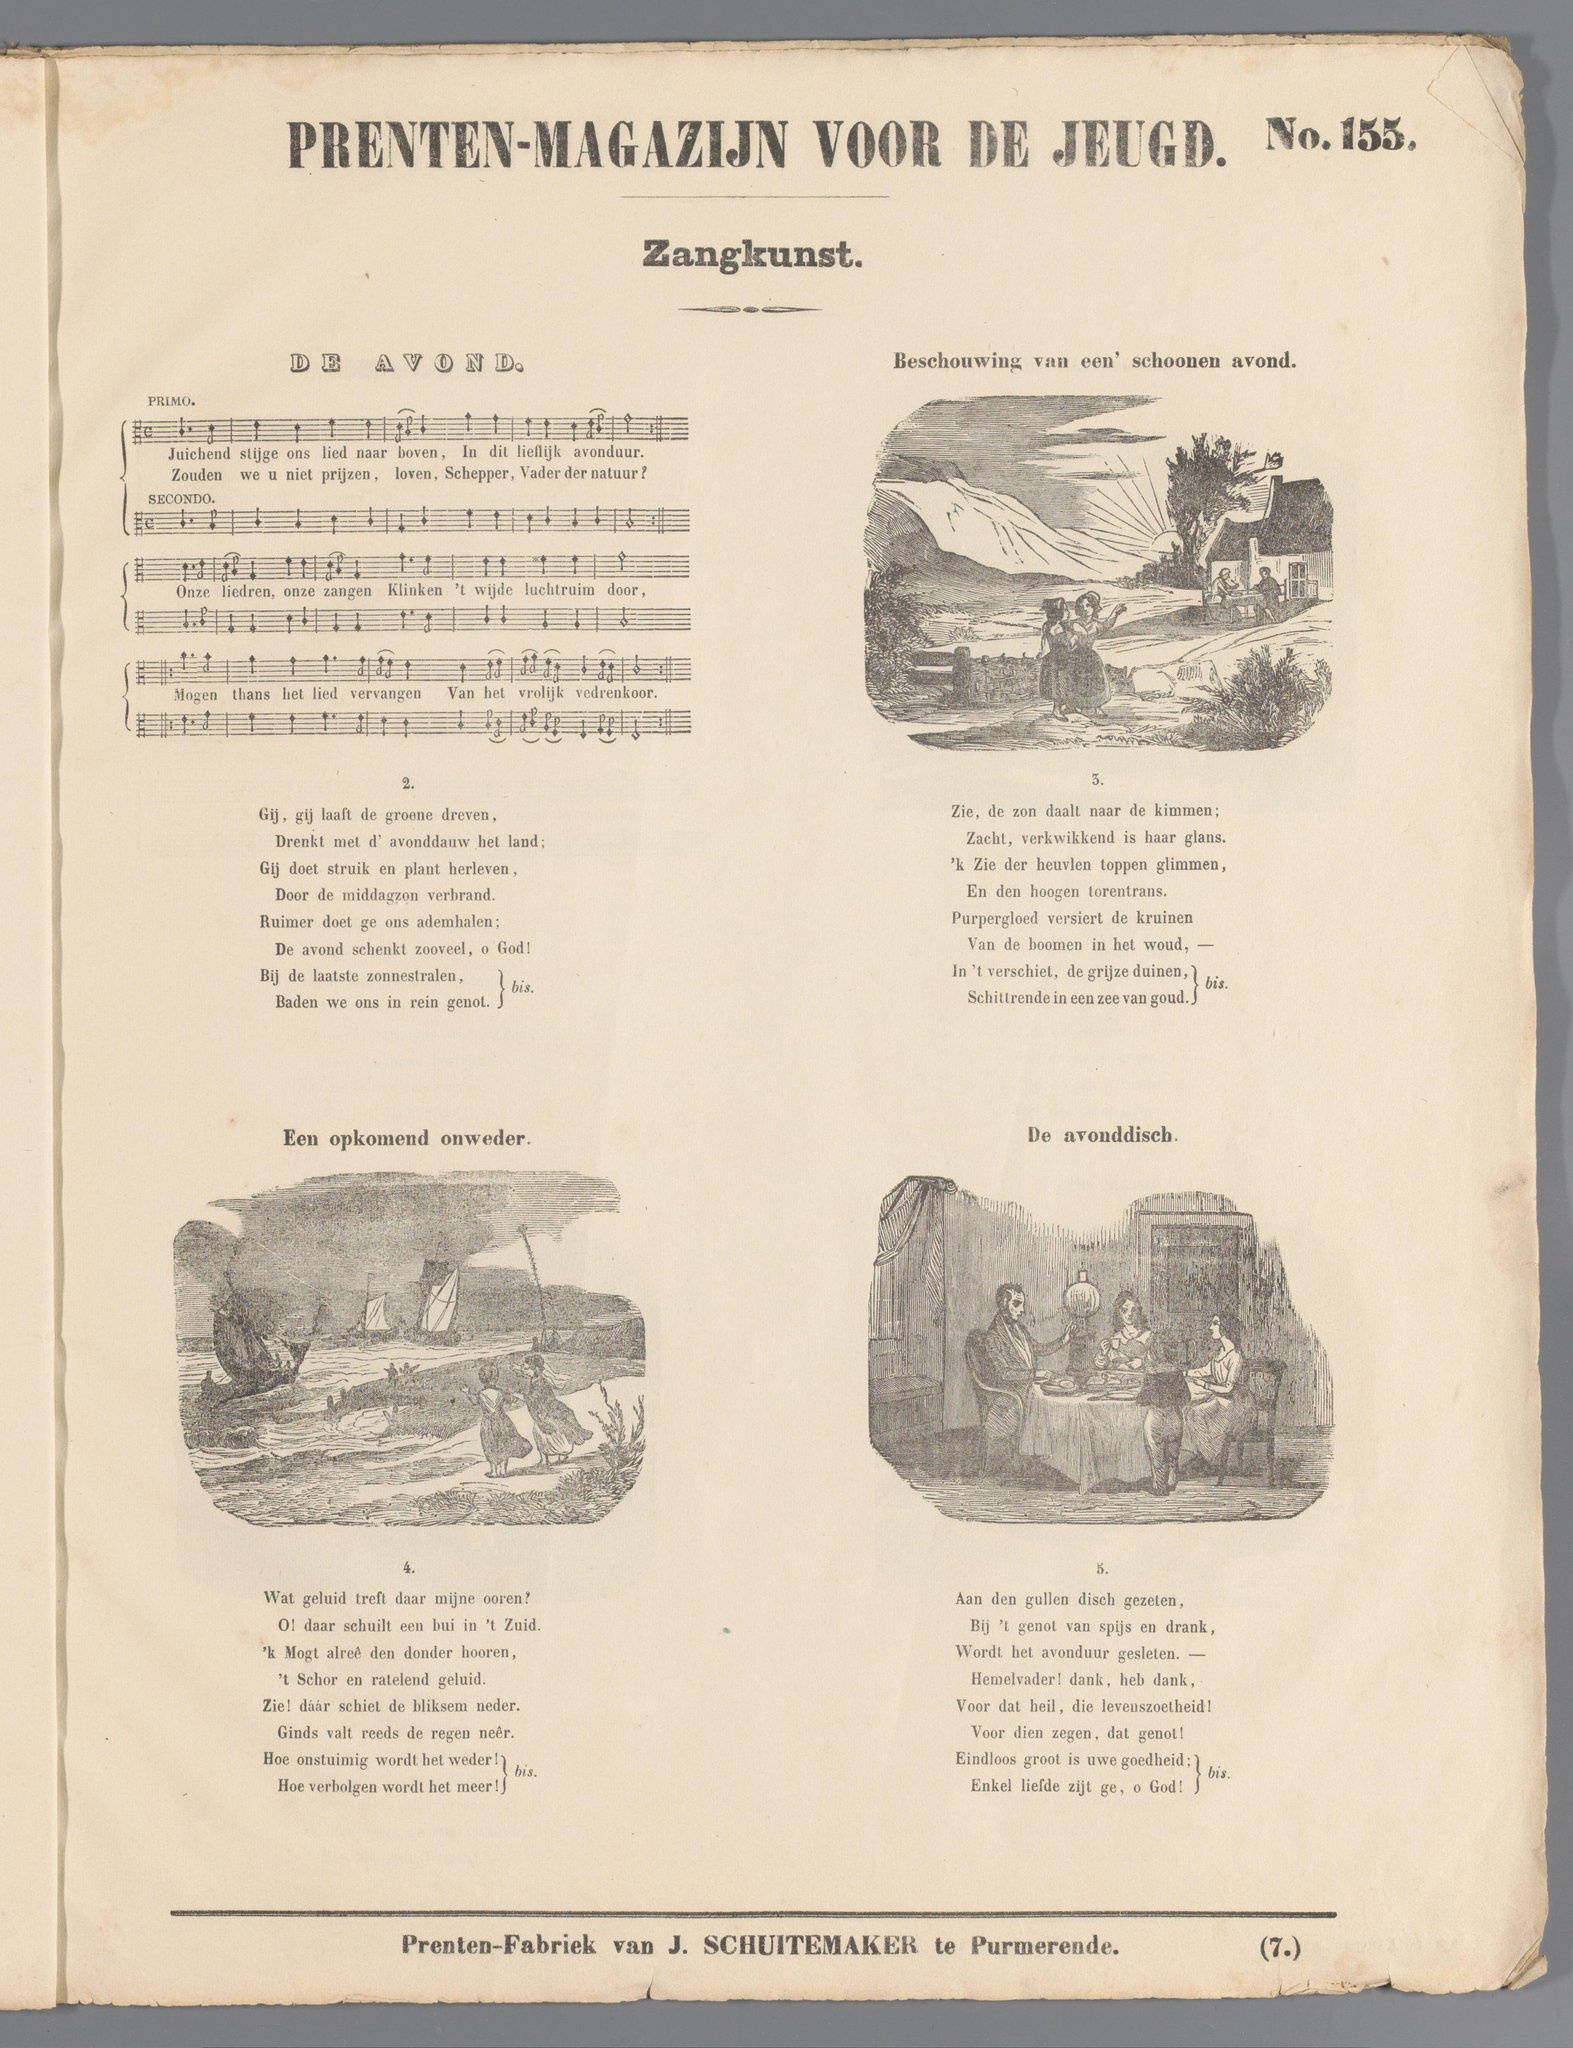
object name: print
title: Prenten-magazijn voor de jeugd / Zangkunst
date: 1853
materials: paper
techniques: letterpress printing, engraving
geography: purmerend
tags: evening, thunderstorm, evening meal, dinner, supper, printed edition of musical score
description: Blad met muziekstuk 'De avond' en 3 voorstellingen: beschouwing van een schone avond, een onkomend onweer en de avonddisch. Onder de voorstellingen diverse coupletten van het muziekstuk. Genummerd rechtsboven: No. 155, linksonder: (7.).